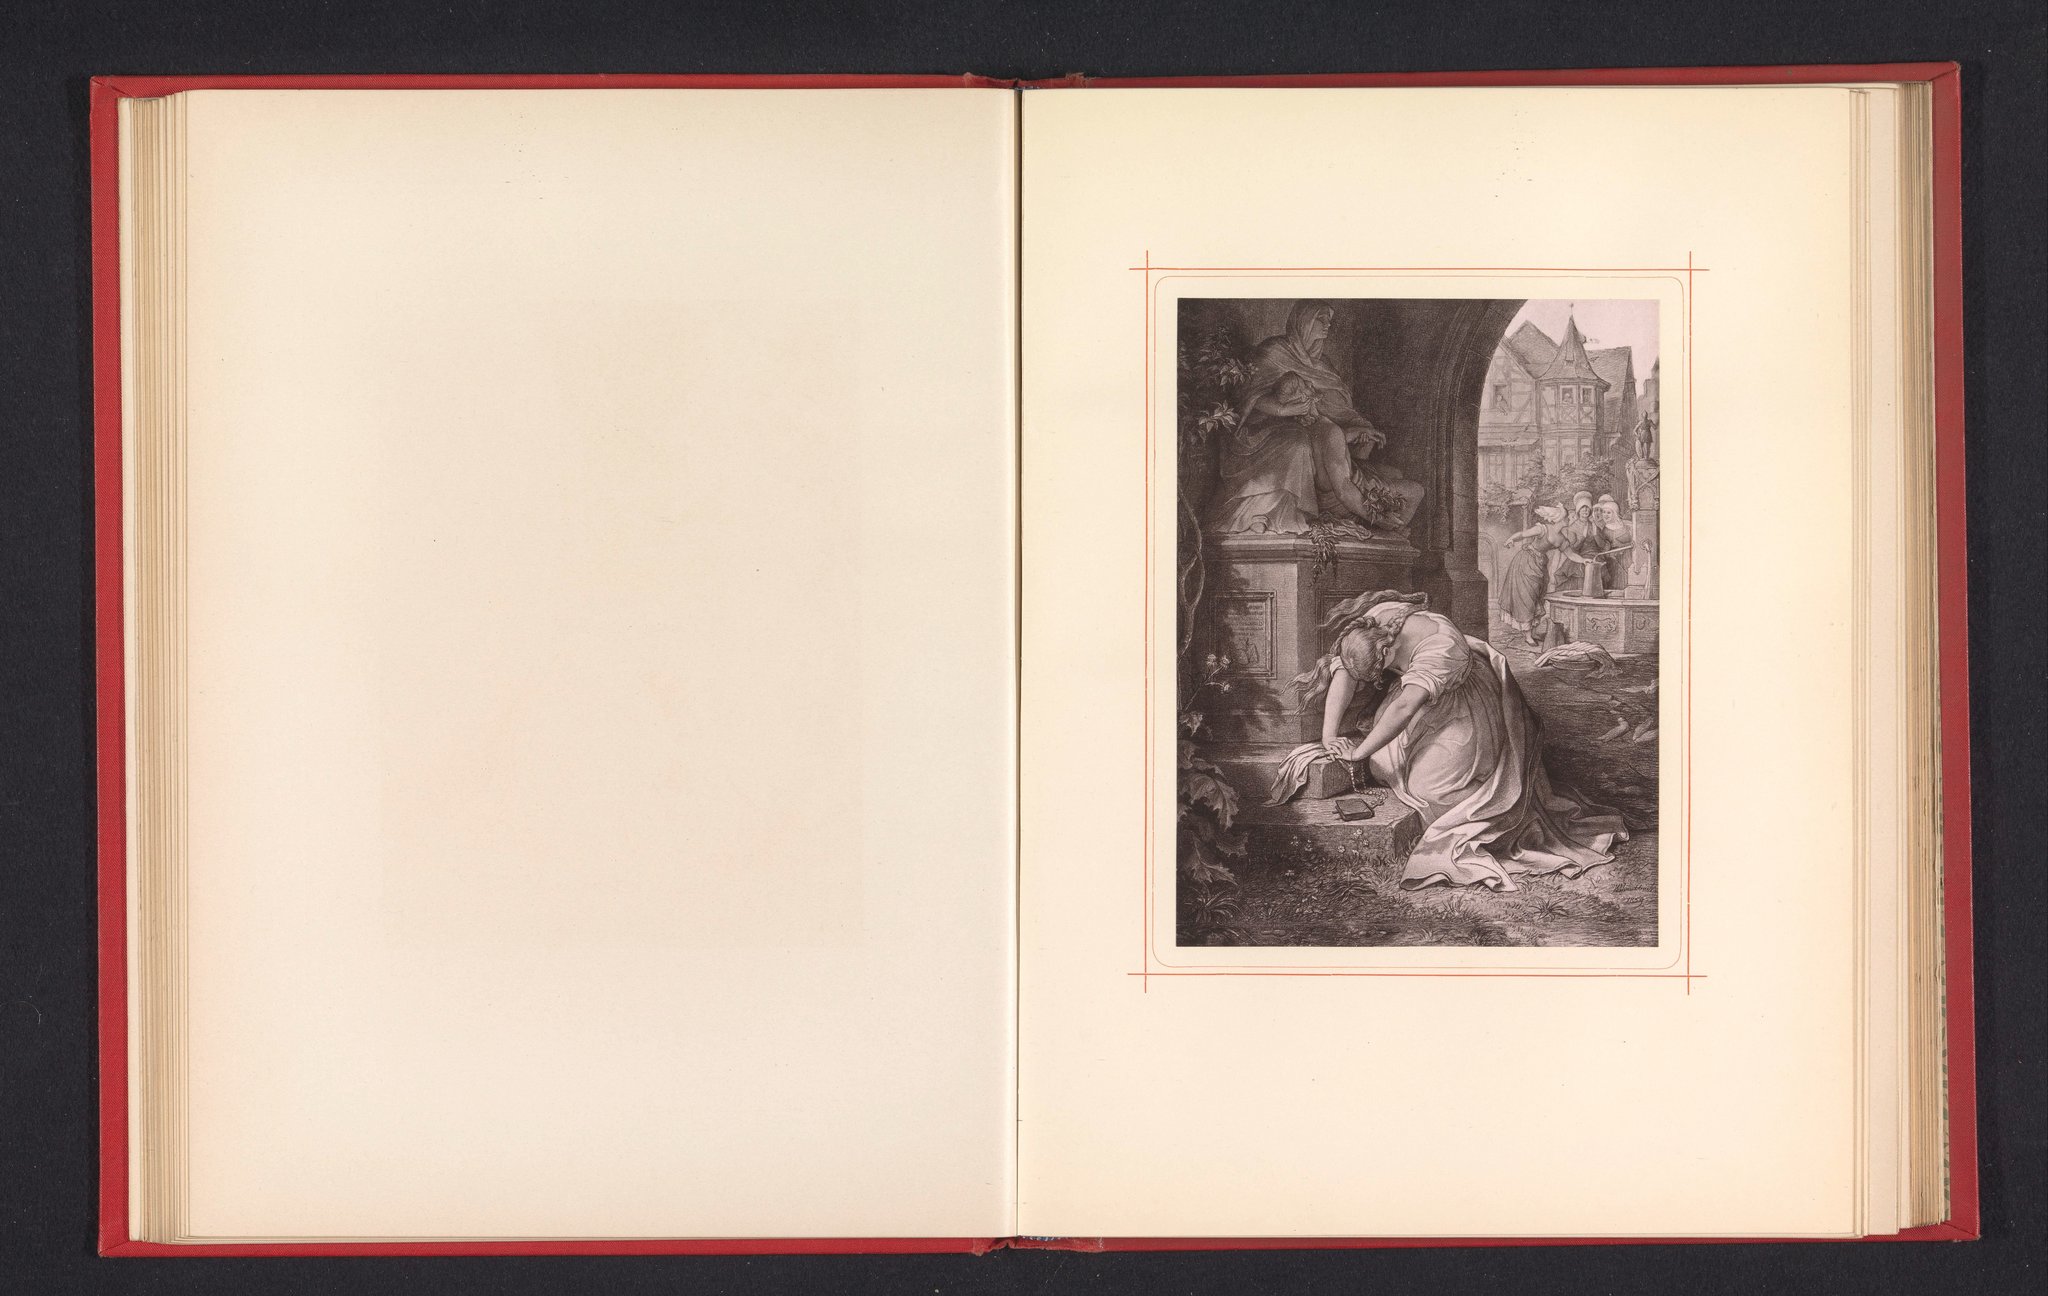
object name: page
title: Fotoreproductie van een tekening, voorstellende Gretchen valt neer voor een sculptuur van de Piëta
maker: Anonymous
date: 1875-1880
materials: paper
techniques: photograph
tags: adult woman, 'pietà ', 'vesperbild', 'marienklage' (no others present): christ, either with or without crown of thorns, mourned by mary, one person praying, (scenes from) specific works of literature: goethe, faust